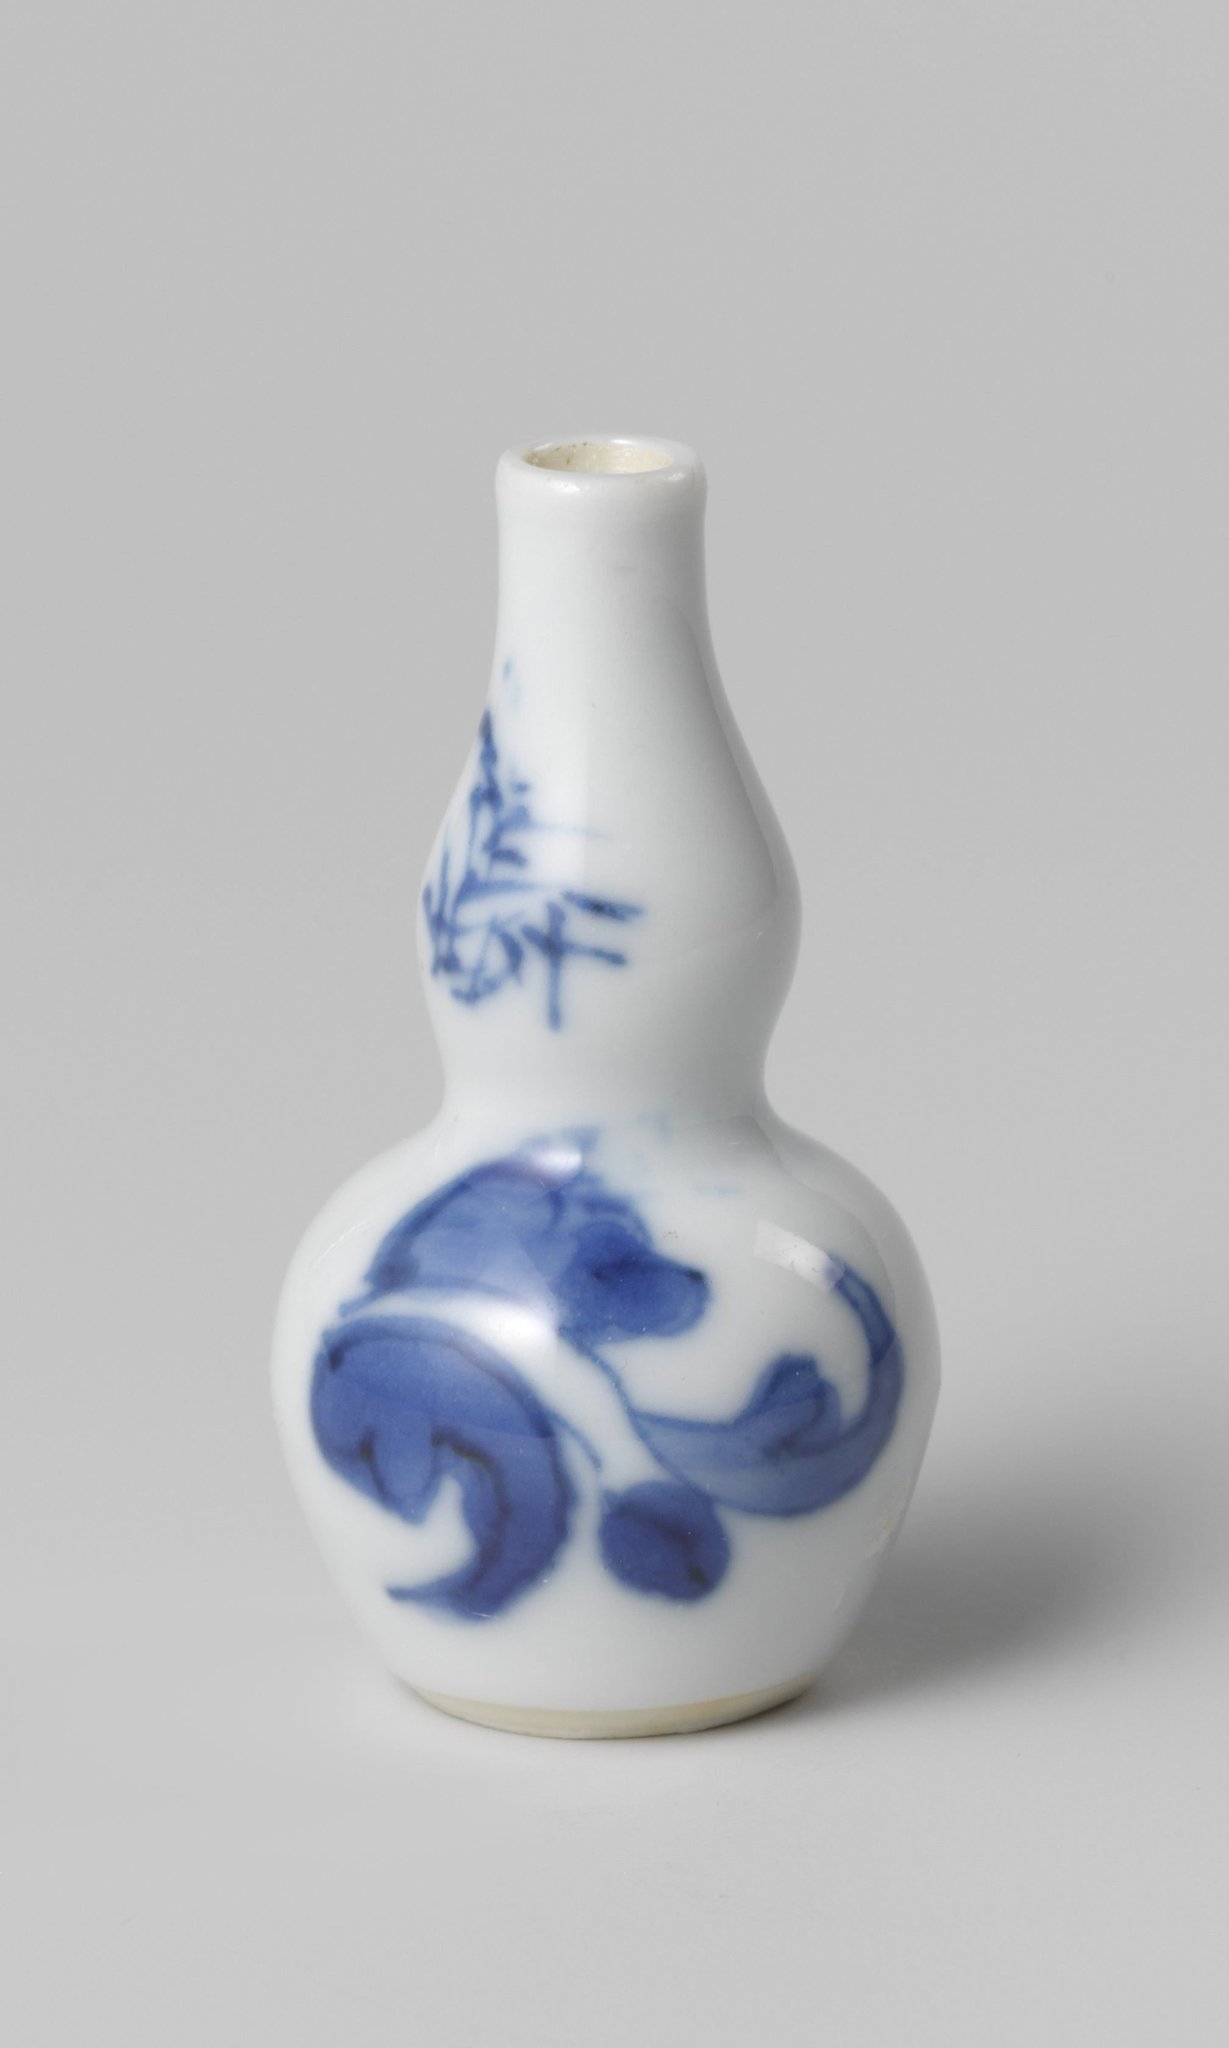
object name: vase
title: Miniature double gourd-shaped vase with foliate scrolls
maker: Anonymous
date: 1675-1724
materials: cobalt, glaze, paint, porcelain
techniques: firing, turning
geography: china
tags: ornament derived from plant forms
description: Miniatuur kalebasvormige vaas van porselein, beschilderd in onderglazuur blauw. Op de wand bladranken en twijgjes. Blauw-wit.